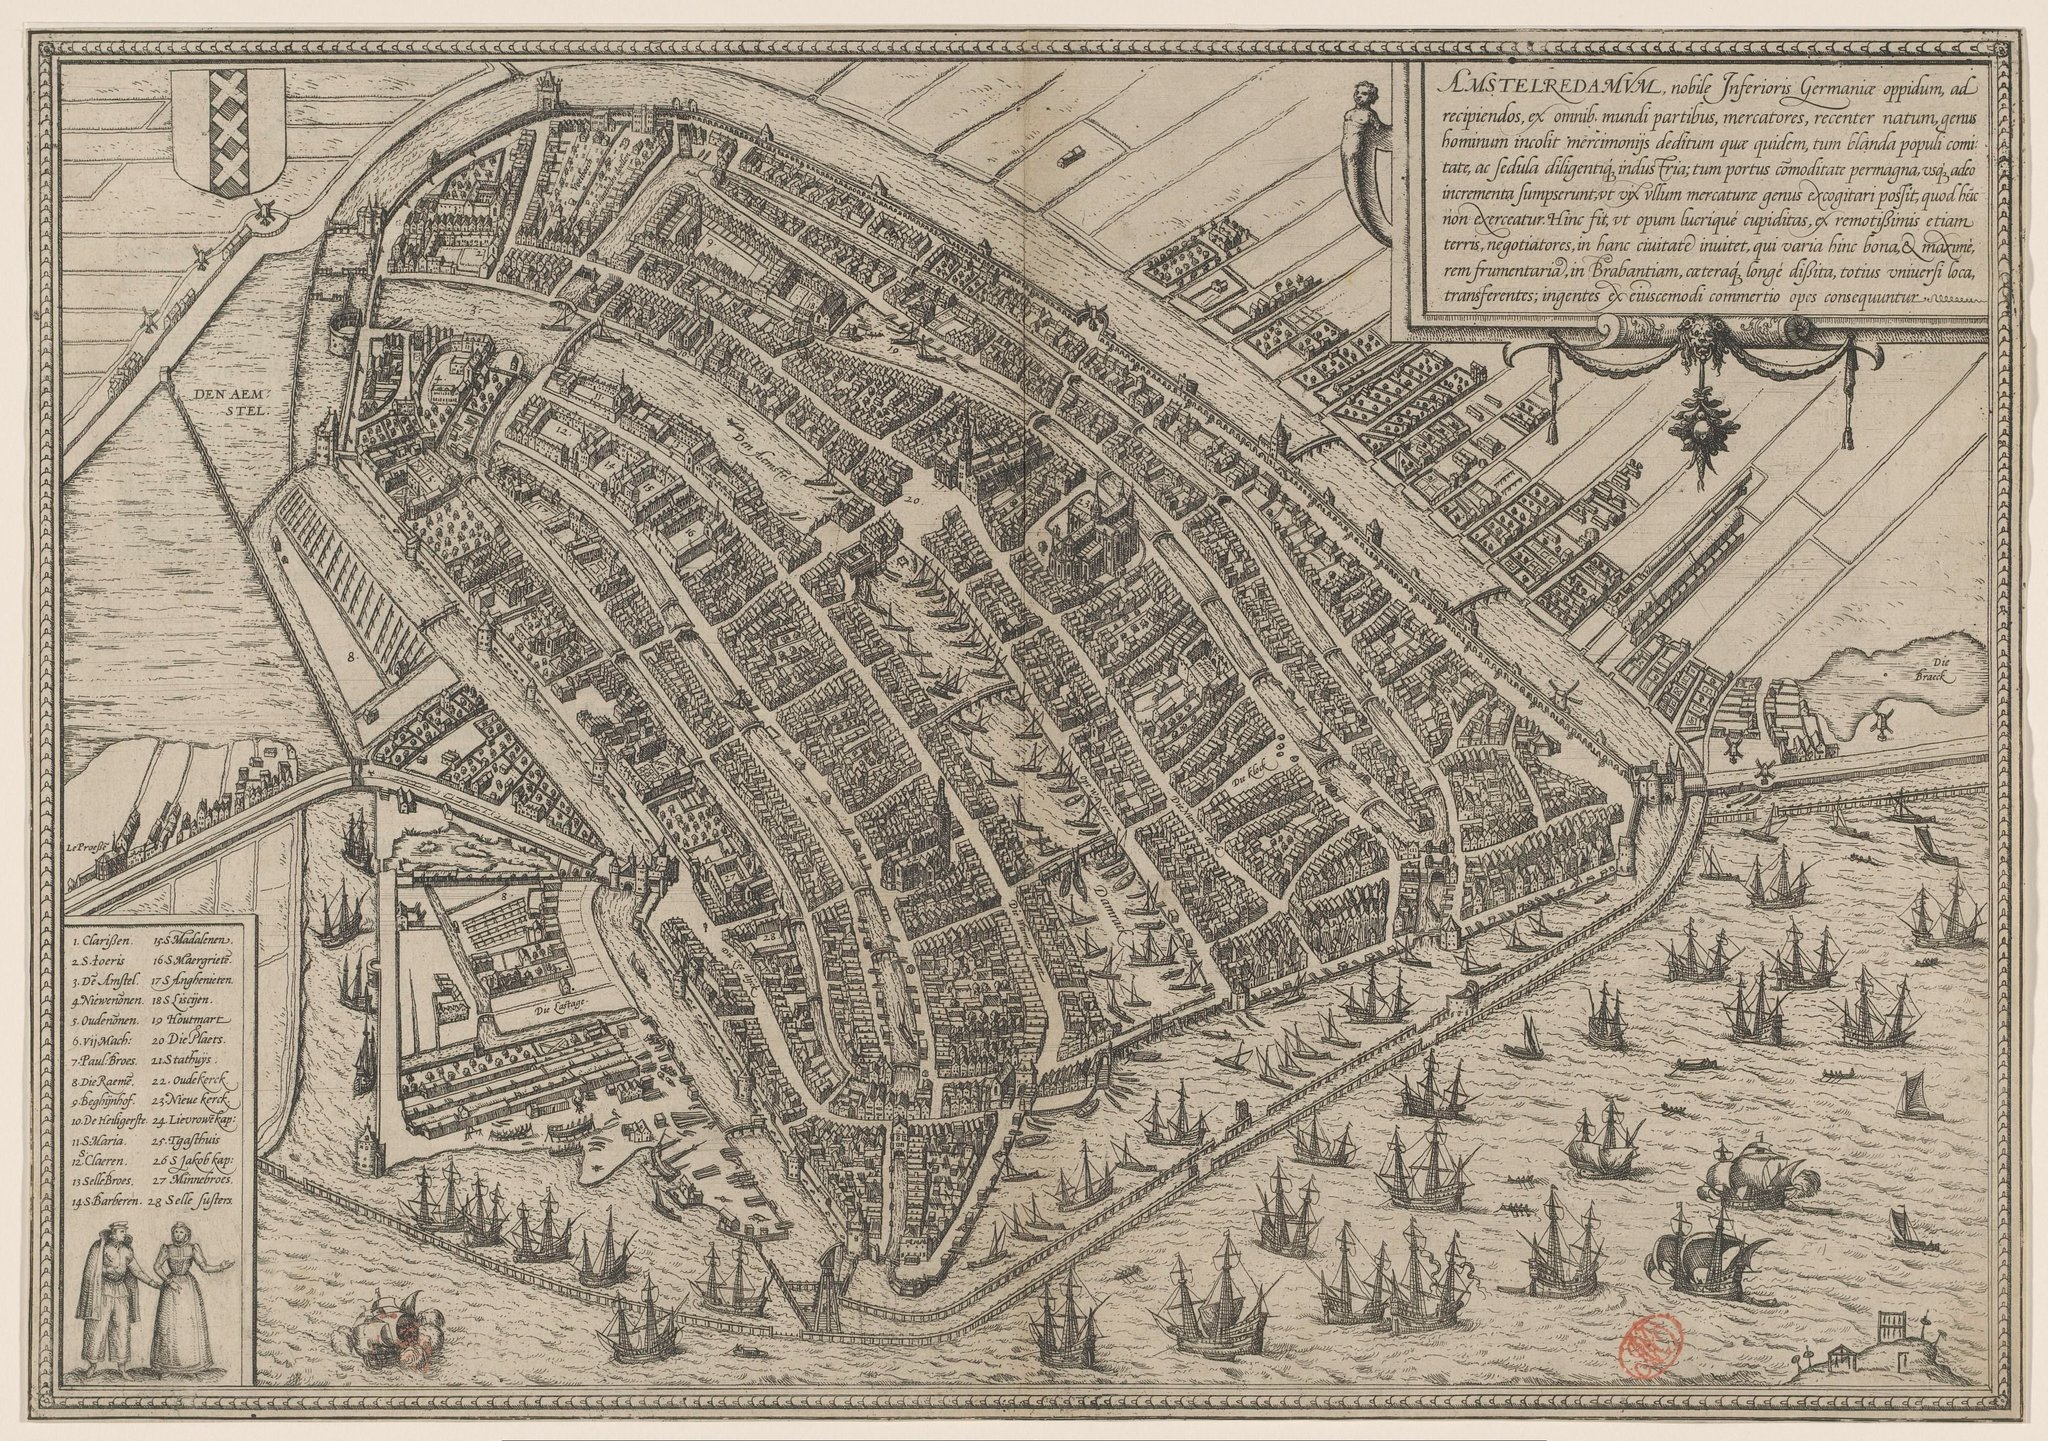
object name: area plan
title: Amstelredamum, nobile Inferioris Germaniae oppidum, ad recipiendos, ex omnib. mondi partibus, mercatores, recenter natum (…)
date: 1572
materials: paper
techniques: engraving, etching, letterpress printing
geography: amsterdam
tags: coat of arms (as symbol of the state, etc.) (+ city; municipal), folk costume, regional costume, maps of cities, amsterdam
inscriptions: collector's mark: Lugt 195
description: Plattegrond in vogelvluchtperspectief. Linksboven het wapen van Amsterdam. Linksonder een cartouche met de legenda 1-28 en twee figuren in kostuum. Rechtsboven de titelcartouche. Oriëntatie: westzuidwest boven. Op verso Latijnse tekst.